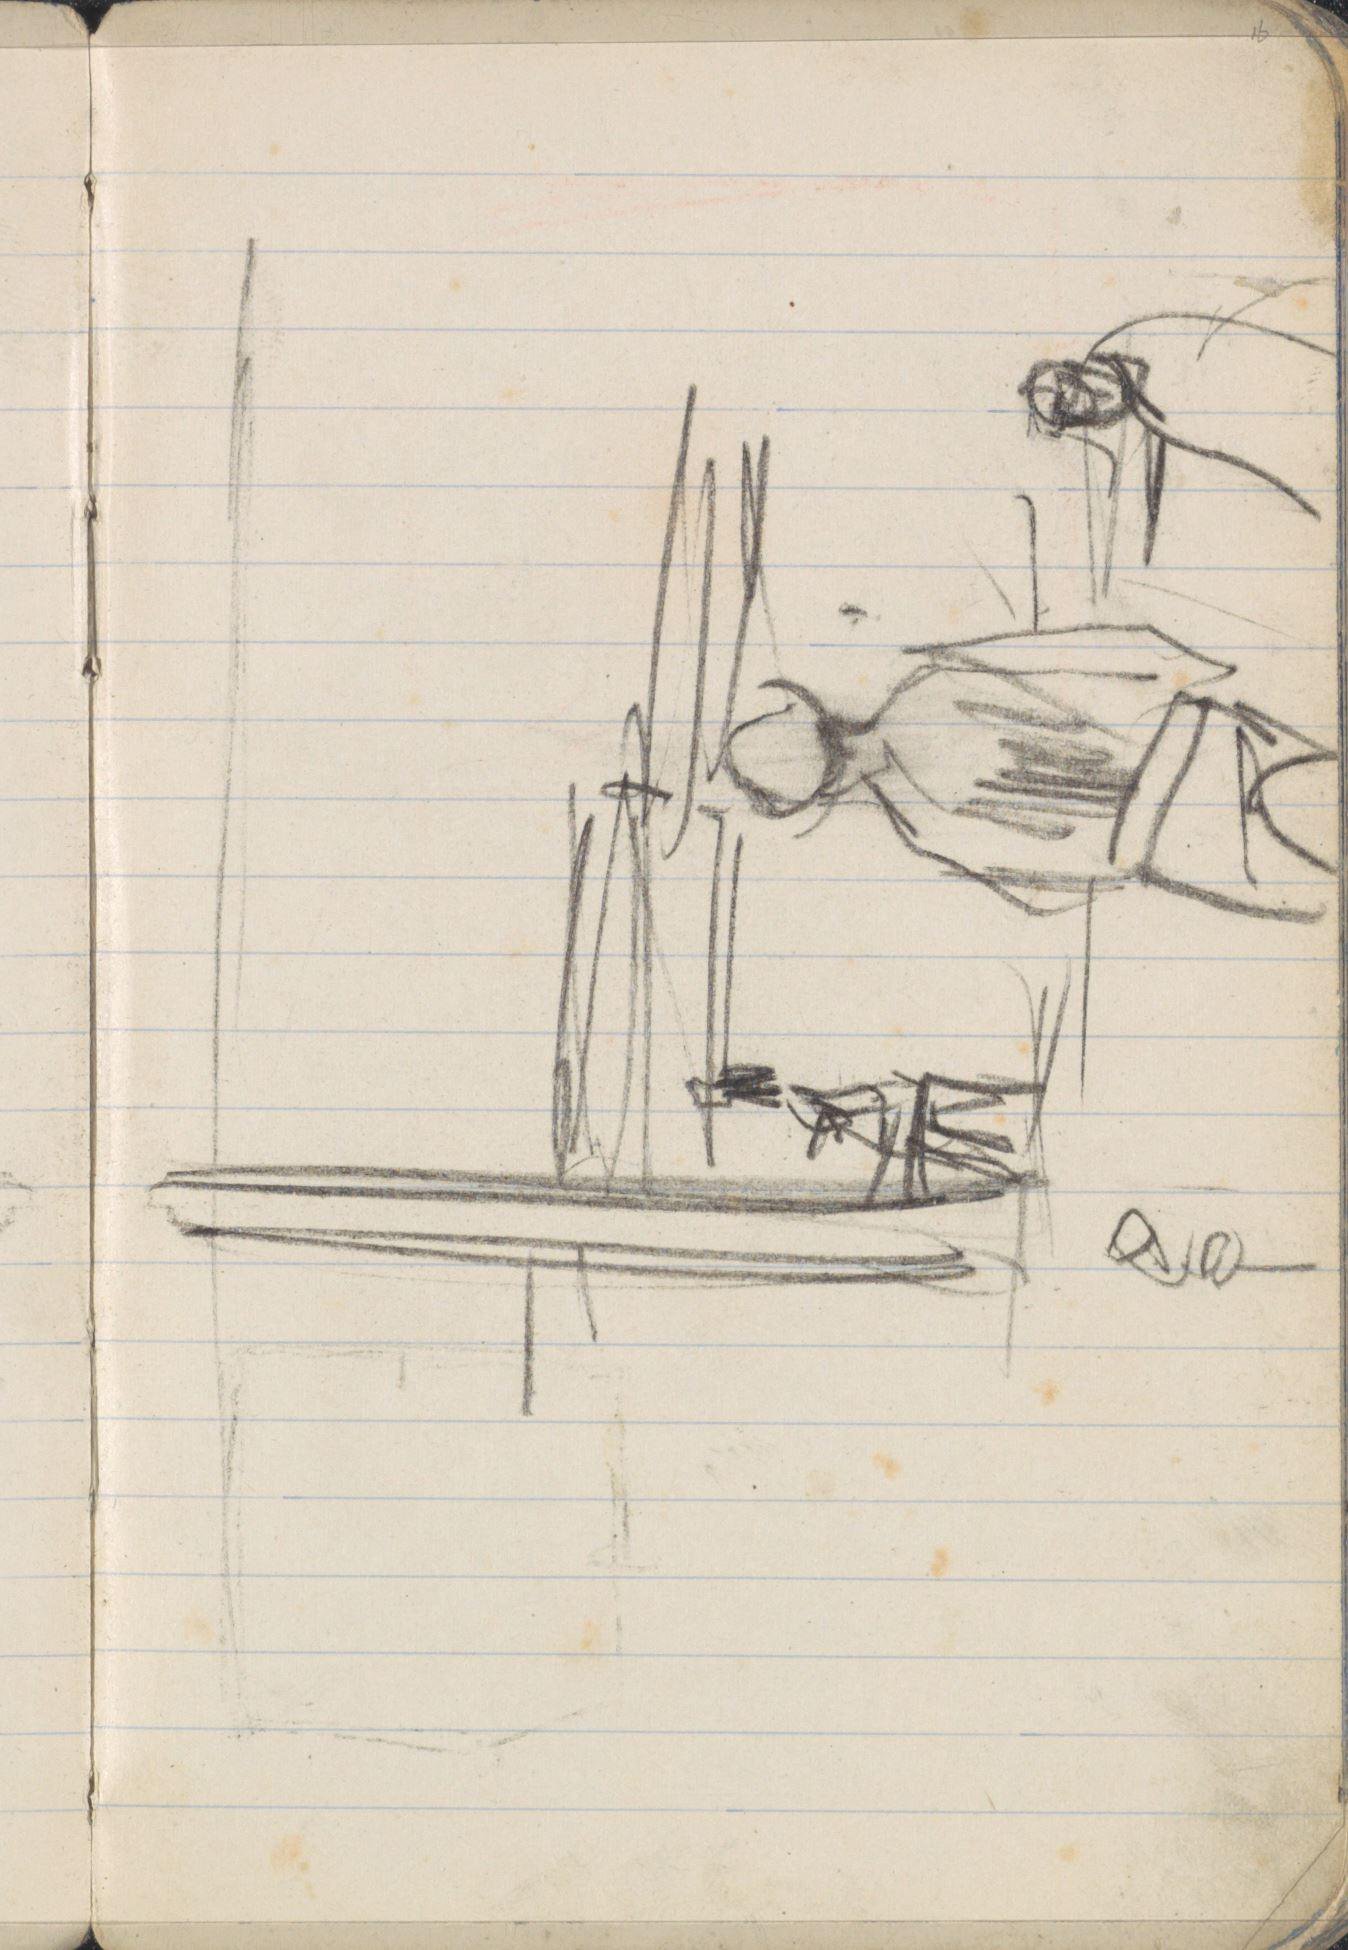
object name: sketchbook leaf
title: Figuren, mogelijk op straat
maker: george hendrik breitner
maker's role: draughtsman, painter, print maker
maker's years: 1857-1923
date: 1896-1897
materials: chalk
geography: amsterdam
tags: street (+ city(-scape) with figures, staffage), amsterdam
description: Pagina 16 uit een schetsboek met 39 bladen.